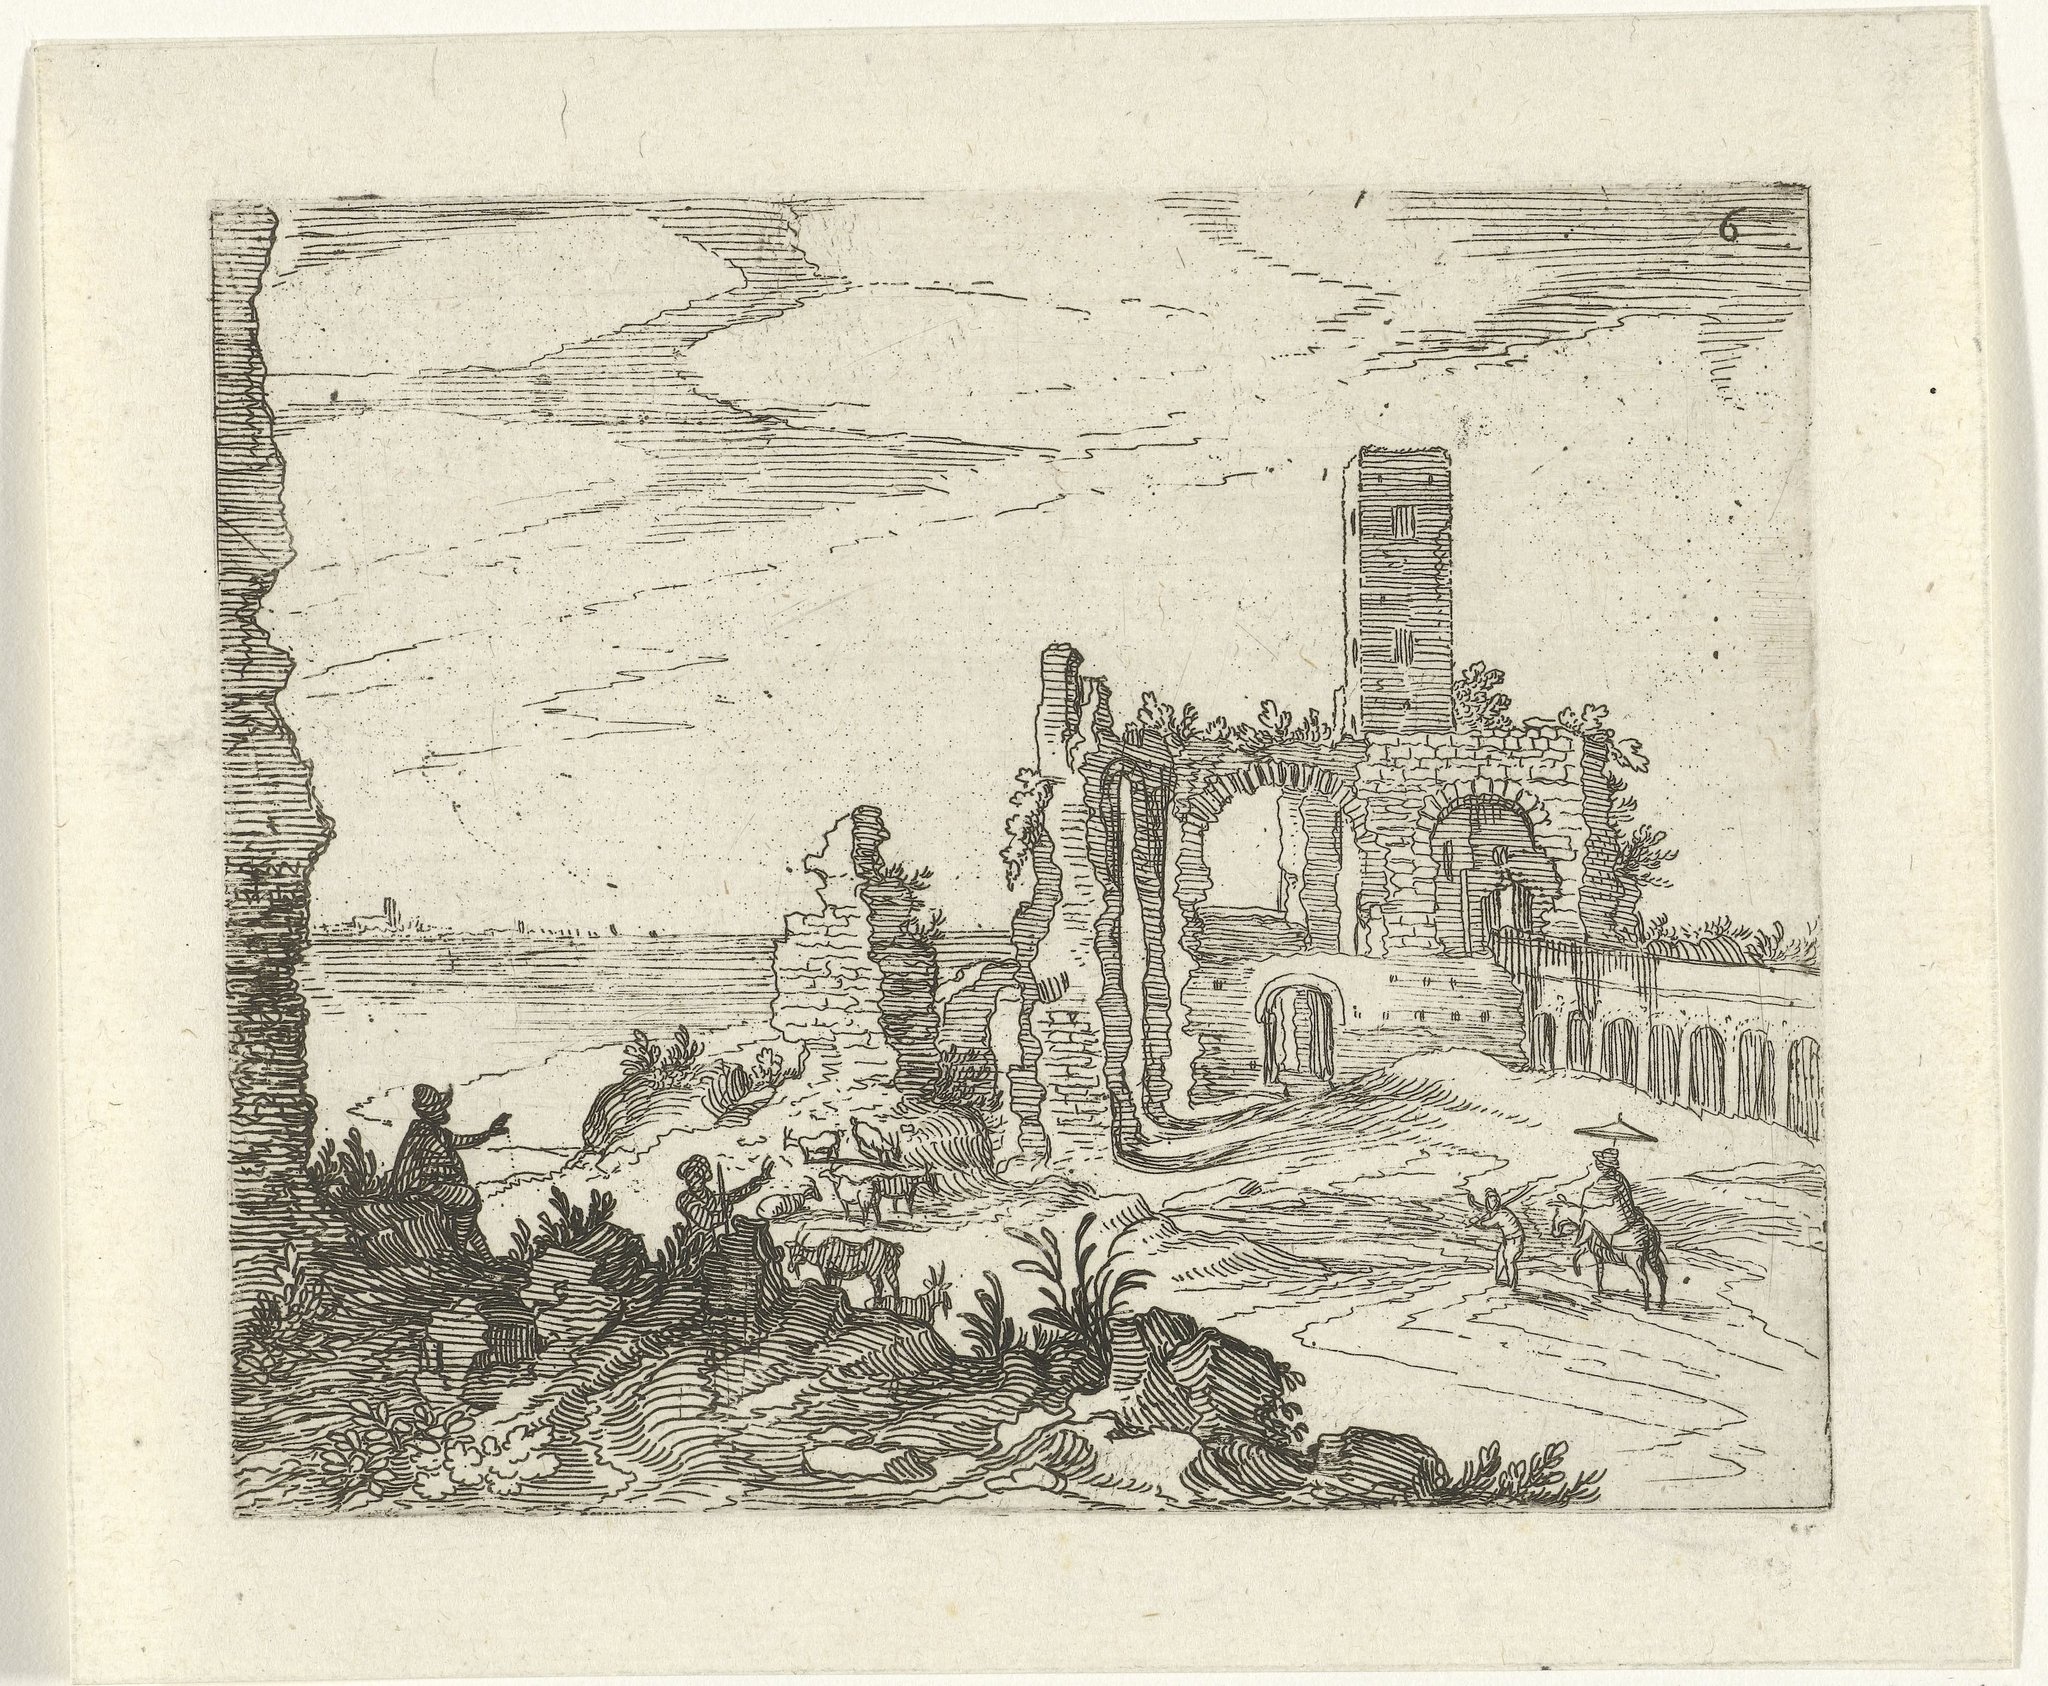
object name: print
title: Romeinse ruïnes (serie 1)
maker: guilliam van nieulandt (ii)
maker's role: draughtsman, print maker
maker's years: 1584-1635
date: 1594-1618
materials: paper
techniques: etching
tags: landscape with ruins, goat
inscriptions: collector's mark: Lugt 240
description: Een ruïne met bogen en een toren aan het water. Rechts een man met een parasol op een ezel en een wandelaar. Links op de voorgrond twee figuren en geiten. Prent uit een serie Romeinse ruïnes.